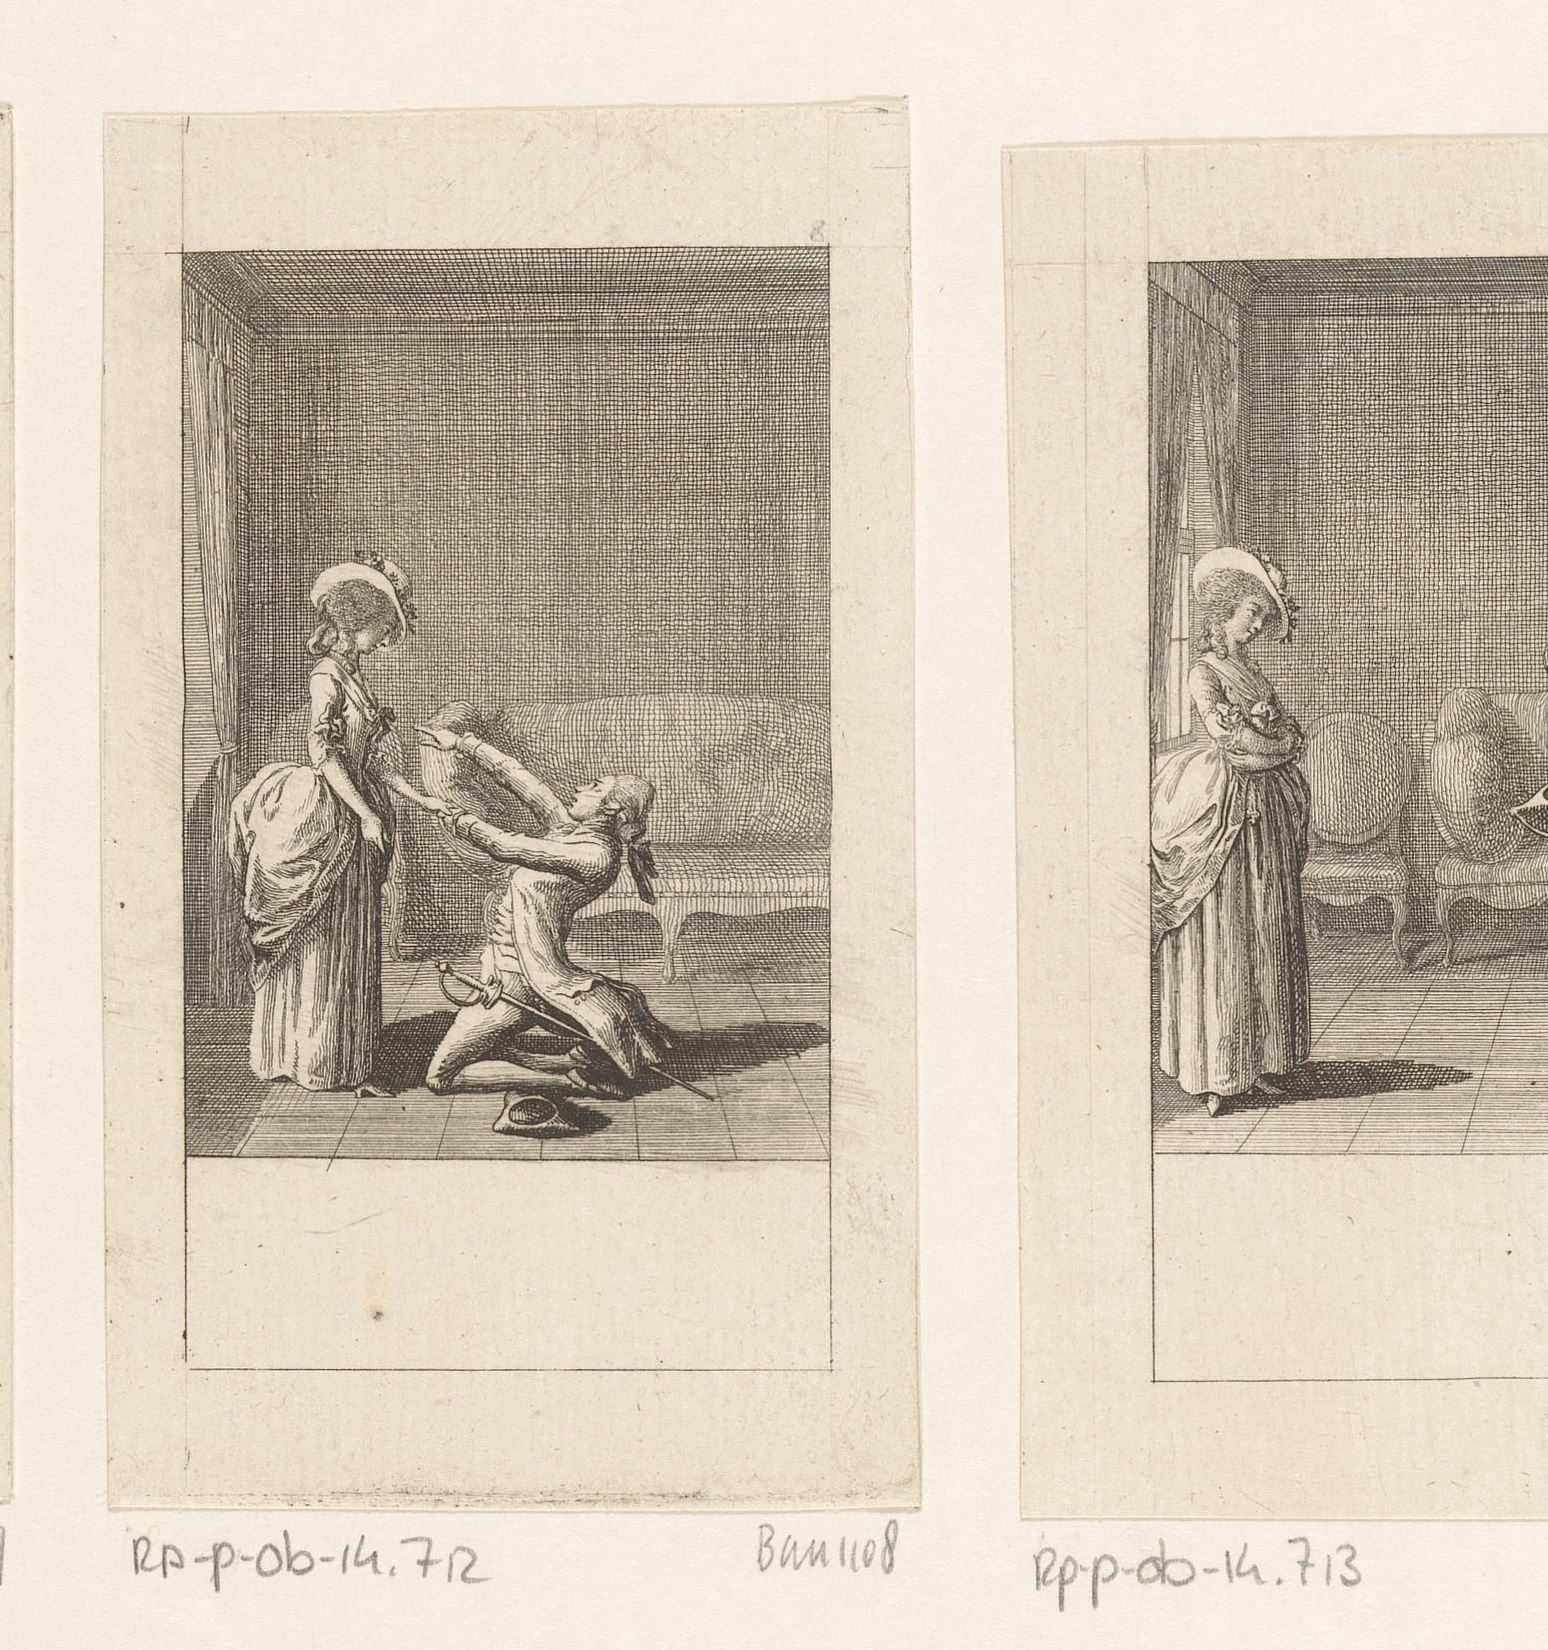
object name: print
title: Linse vraagt Charlotte wie de man is op wie ze verliefd is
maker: daniel nikolaus chodowiecki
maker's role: draughtsman, print maker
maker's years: 1726-1801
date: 1784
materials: paper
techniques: etching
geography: berlin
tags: literature, kneeling figure, index finger forwards, pointing, indicating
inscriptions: collector's mark: Lugt 2228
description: Vervaardigd voor Christian Friedrich Bretzners 'Eheprocurator'. Latere staat gebruikt voor: Konigl. Grosbrit. Genealogischen Kalender auf das Jahr 1785. Lauenburg: J. G. Berenberg, 1784.